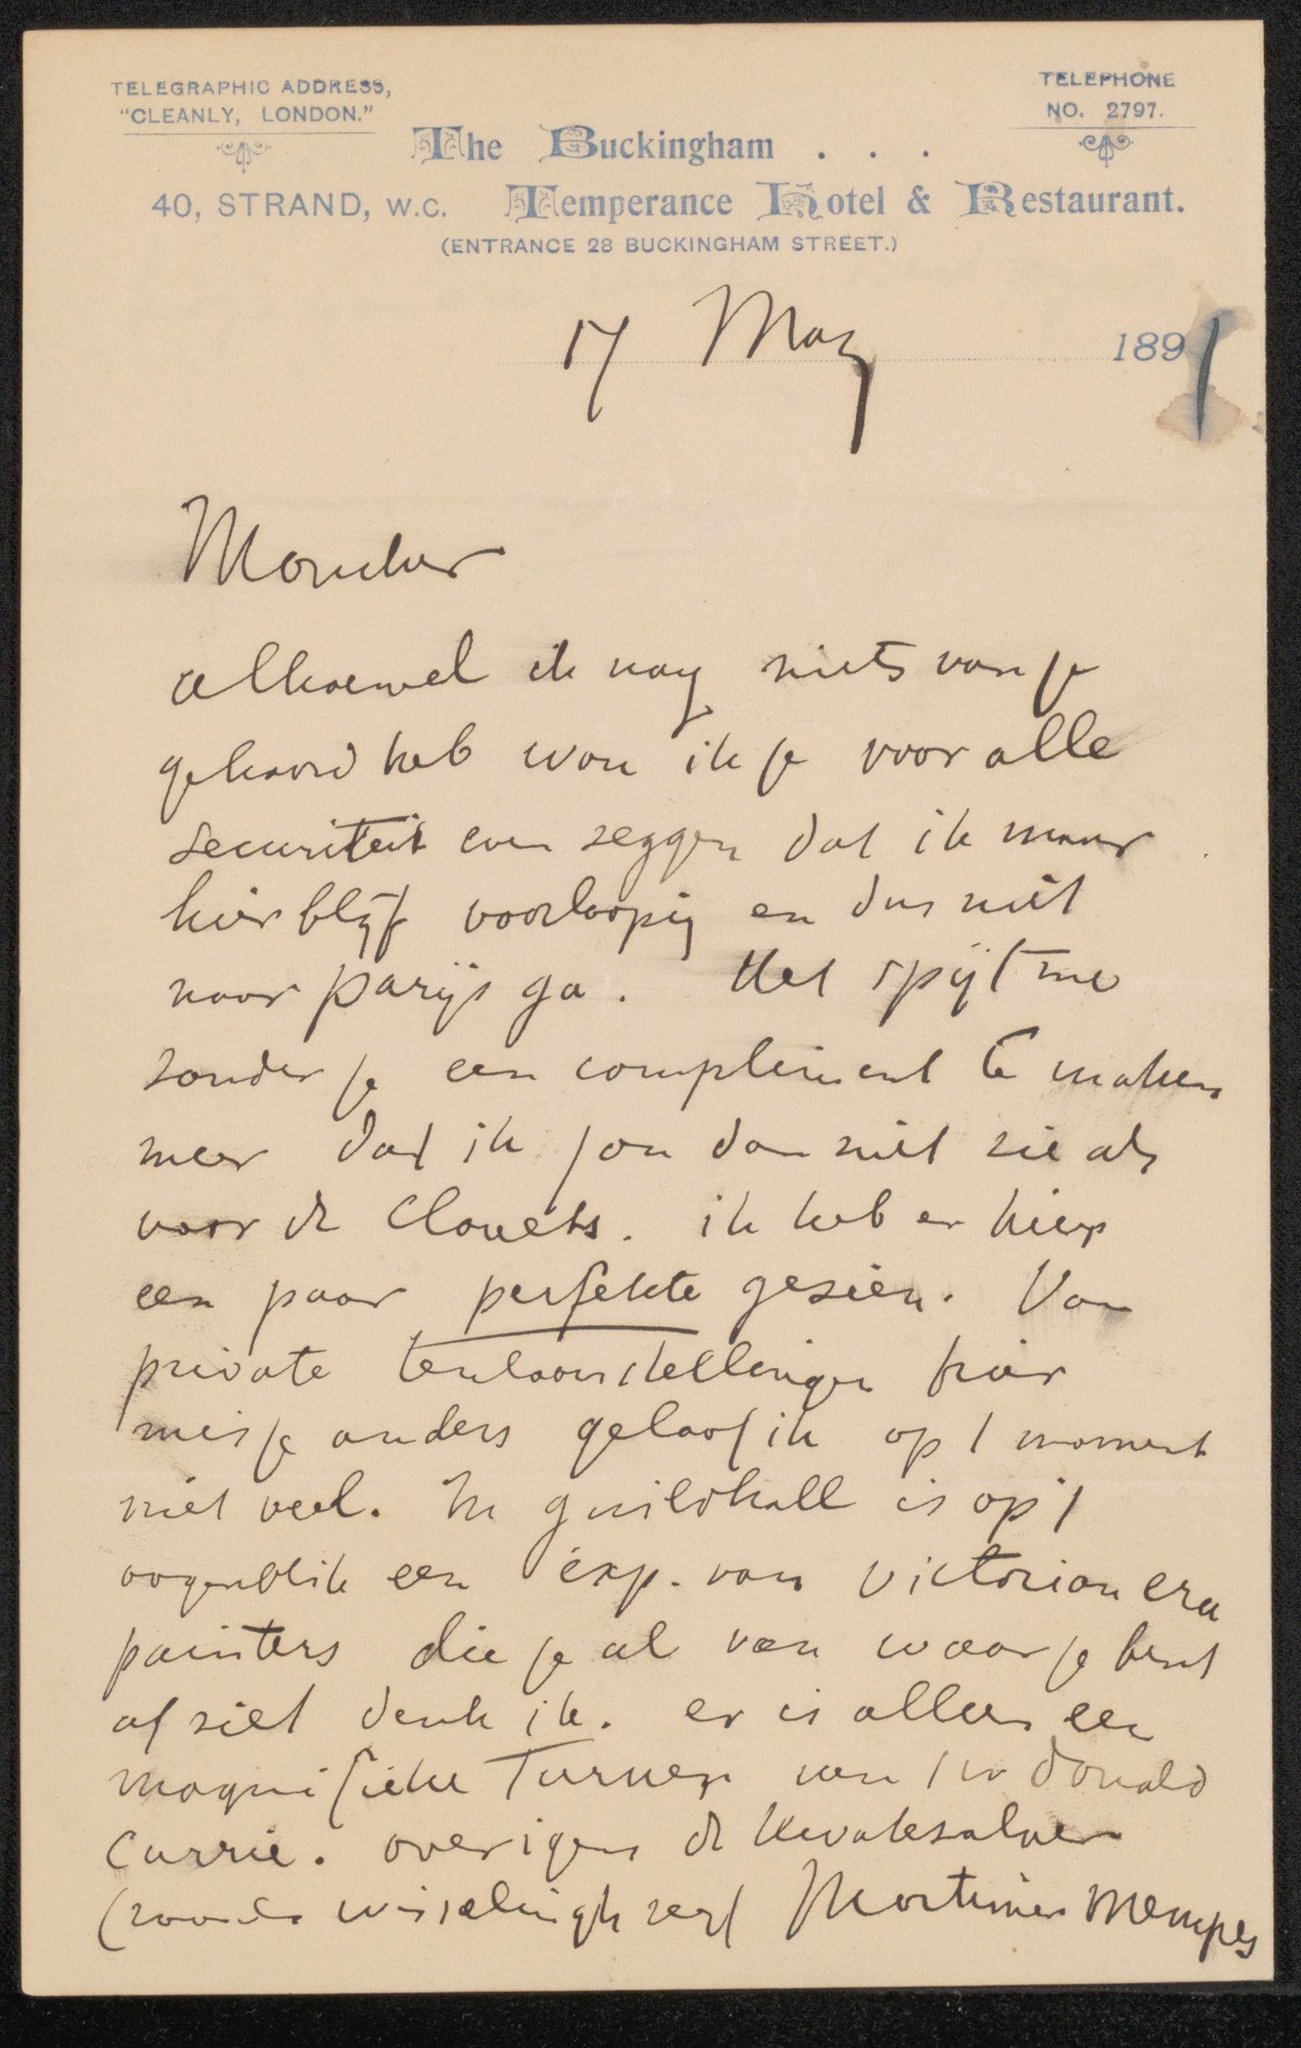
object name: letter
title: Brief aan Jan Veth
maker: isaac israels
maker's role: draughtsman, painter, print maker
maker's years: 1865-1934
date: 1891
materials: ink, paper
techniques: pen, printing, writing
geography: london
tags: the hague, johannes bosboom, dordrecht, amsterdam, designer, jan veth, matthijs maris, narcisse virgile diaz de la peña, paris, théodore rousseau, jacob maris, painter, print maker, draughtsman, jean françois millet, london, joseph mallord william turner, elbert jan van wisselingh, exhibition ~ art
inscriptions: collector's mark: ‘RPK’